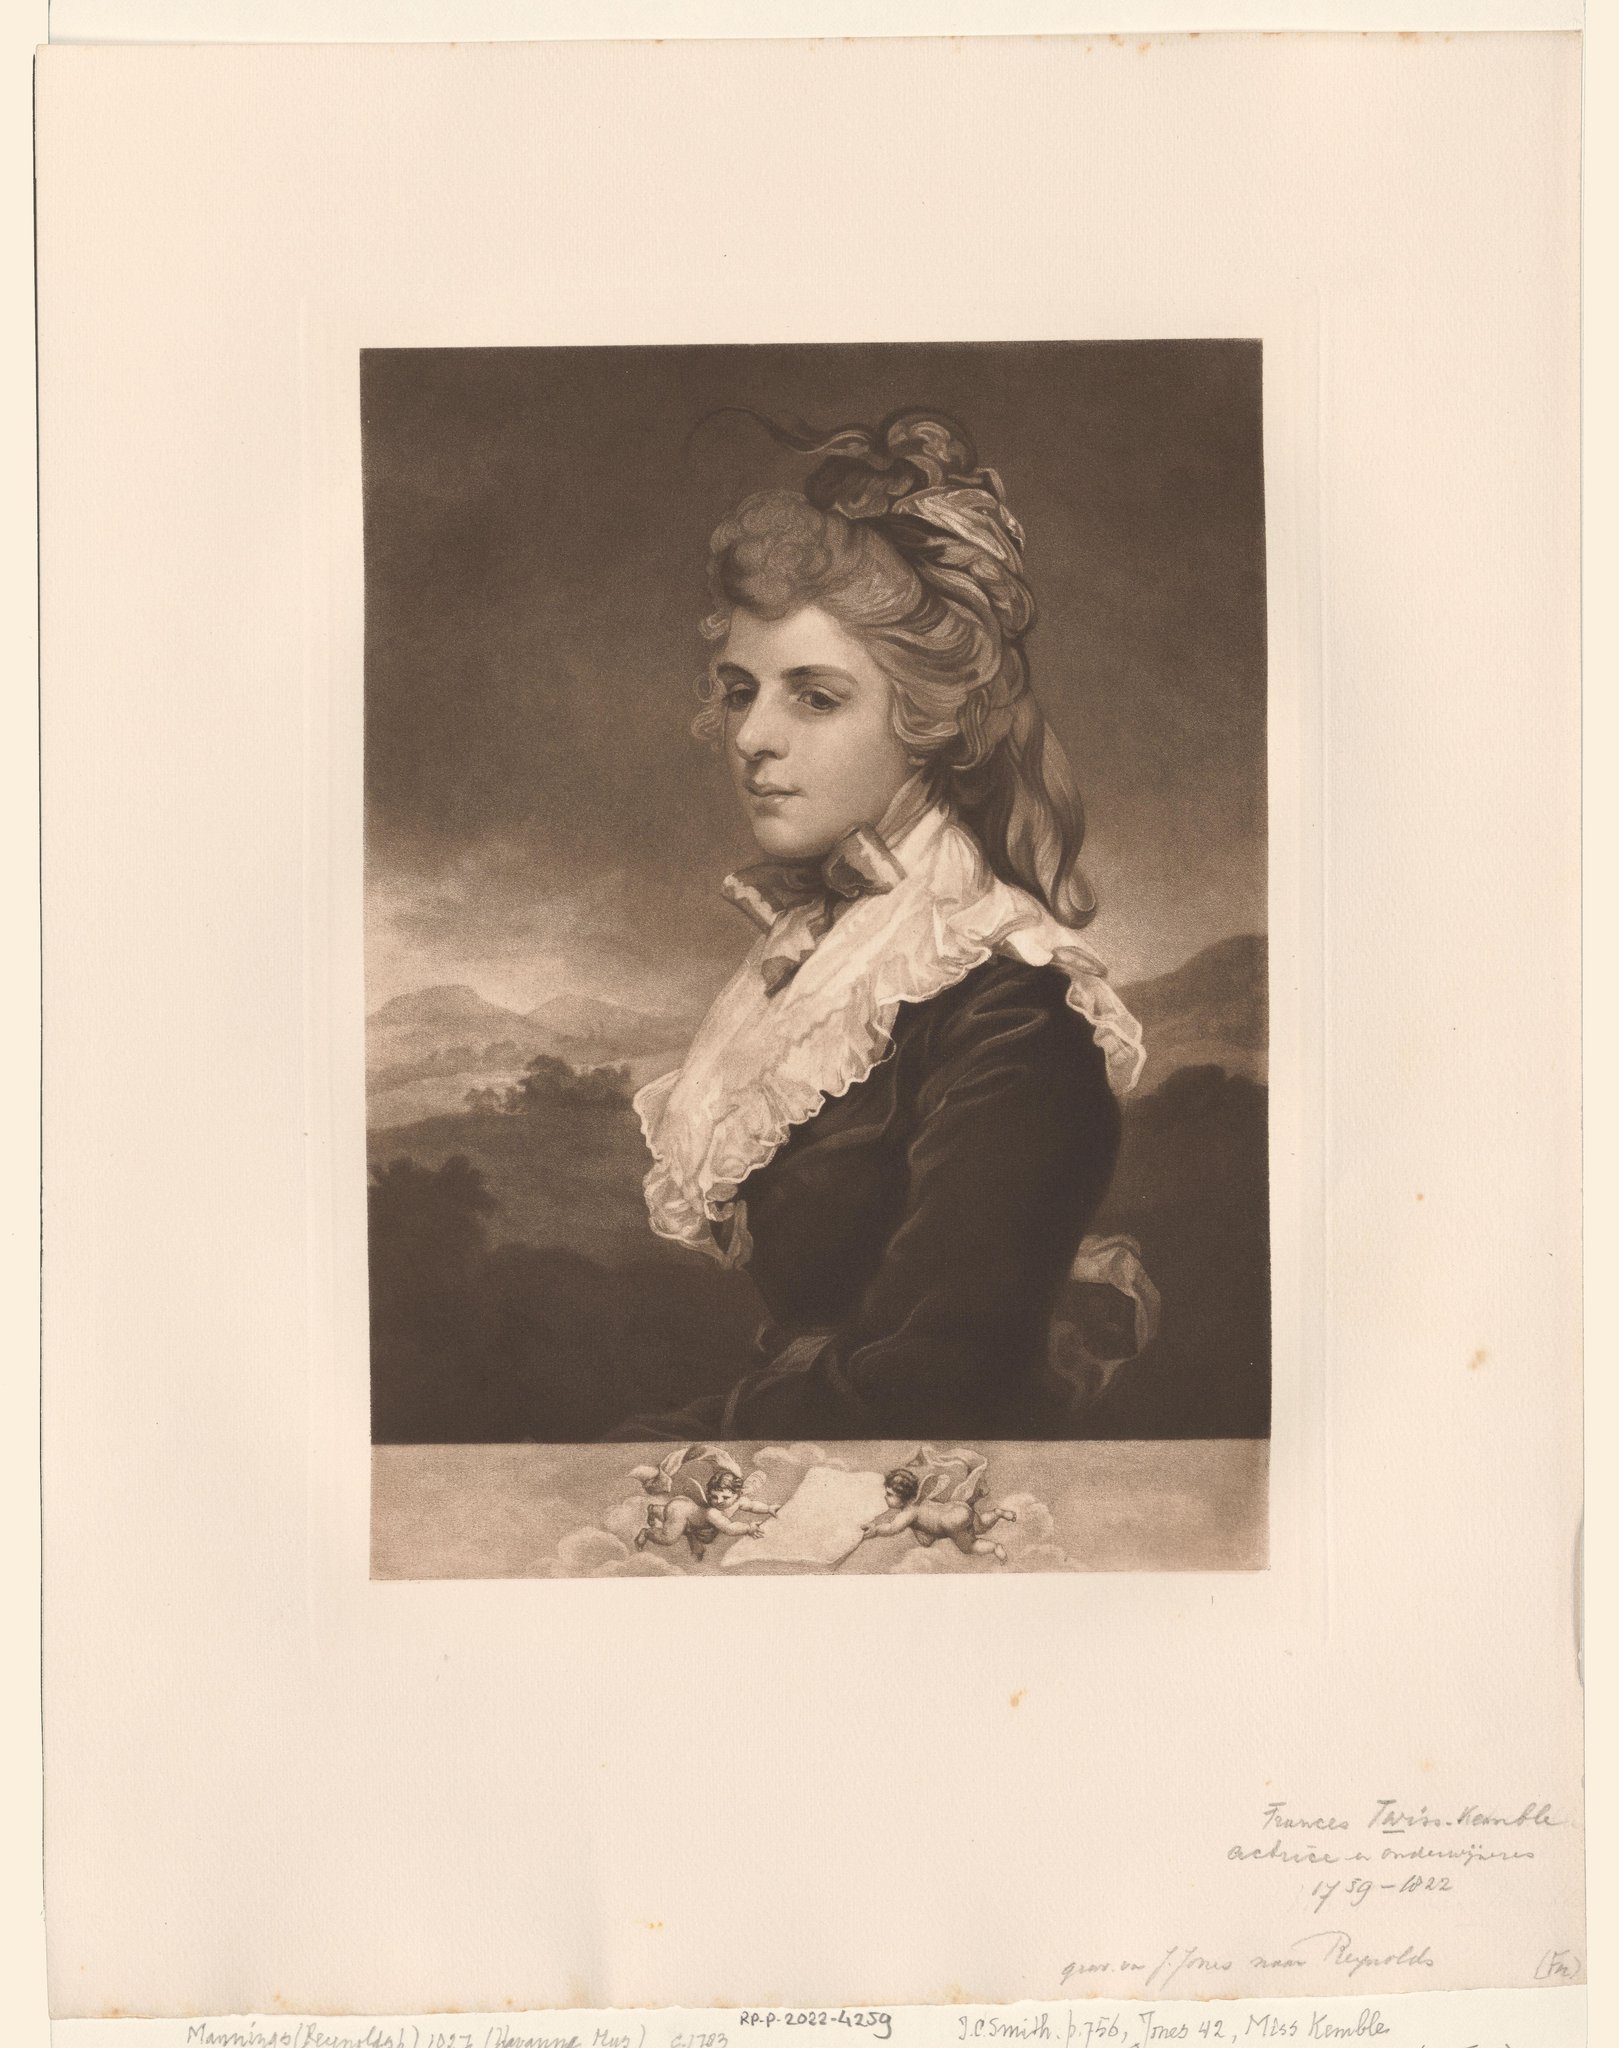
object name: photomechanical print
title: Portret van Frances Kemble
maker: Anonymous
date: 1870-1915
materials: paper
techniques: photoaquatint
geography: united kingdom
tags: historical persons - bb - woman, portrait of actor, actress